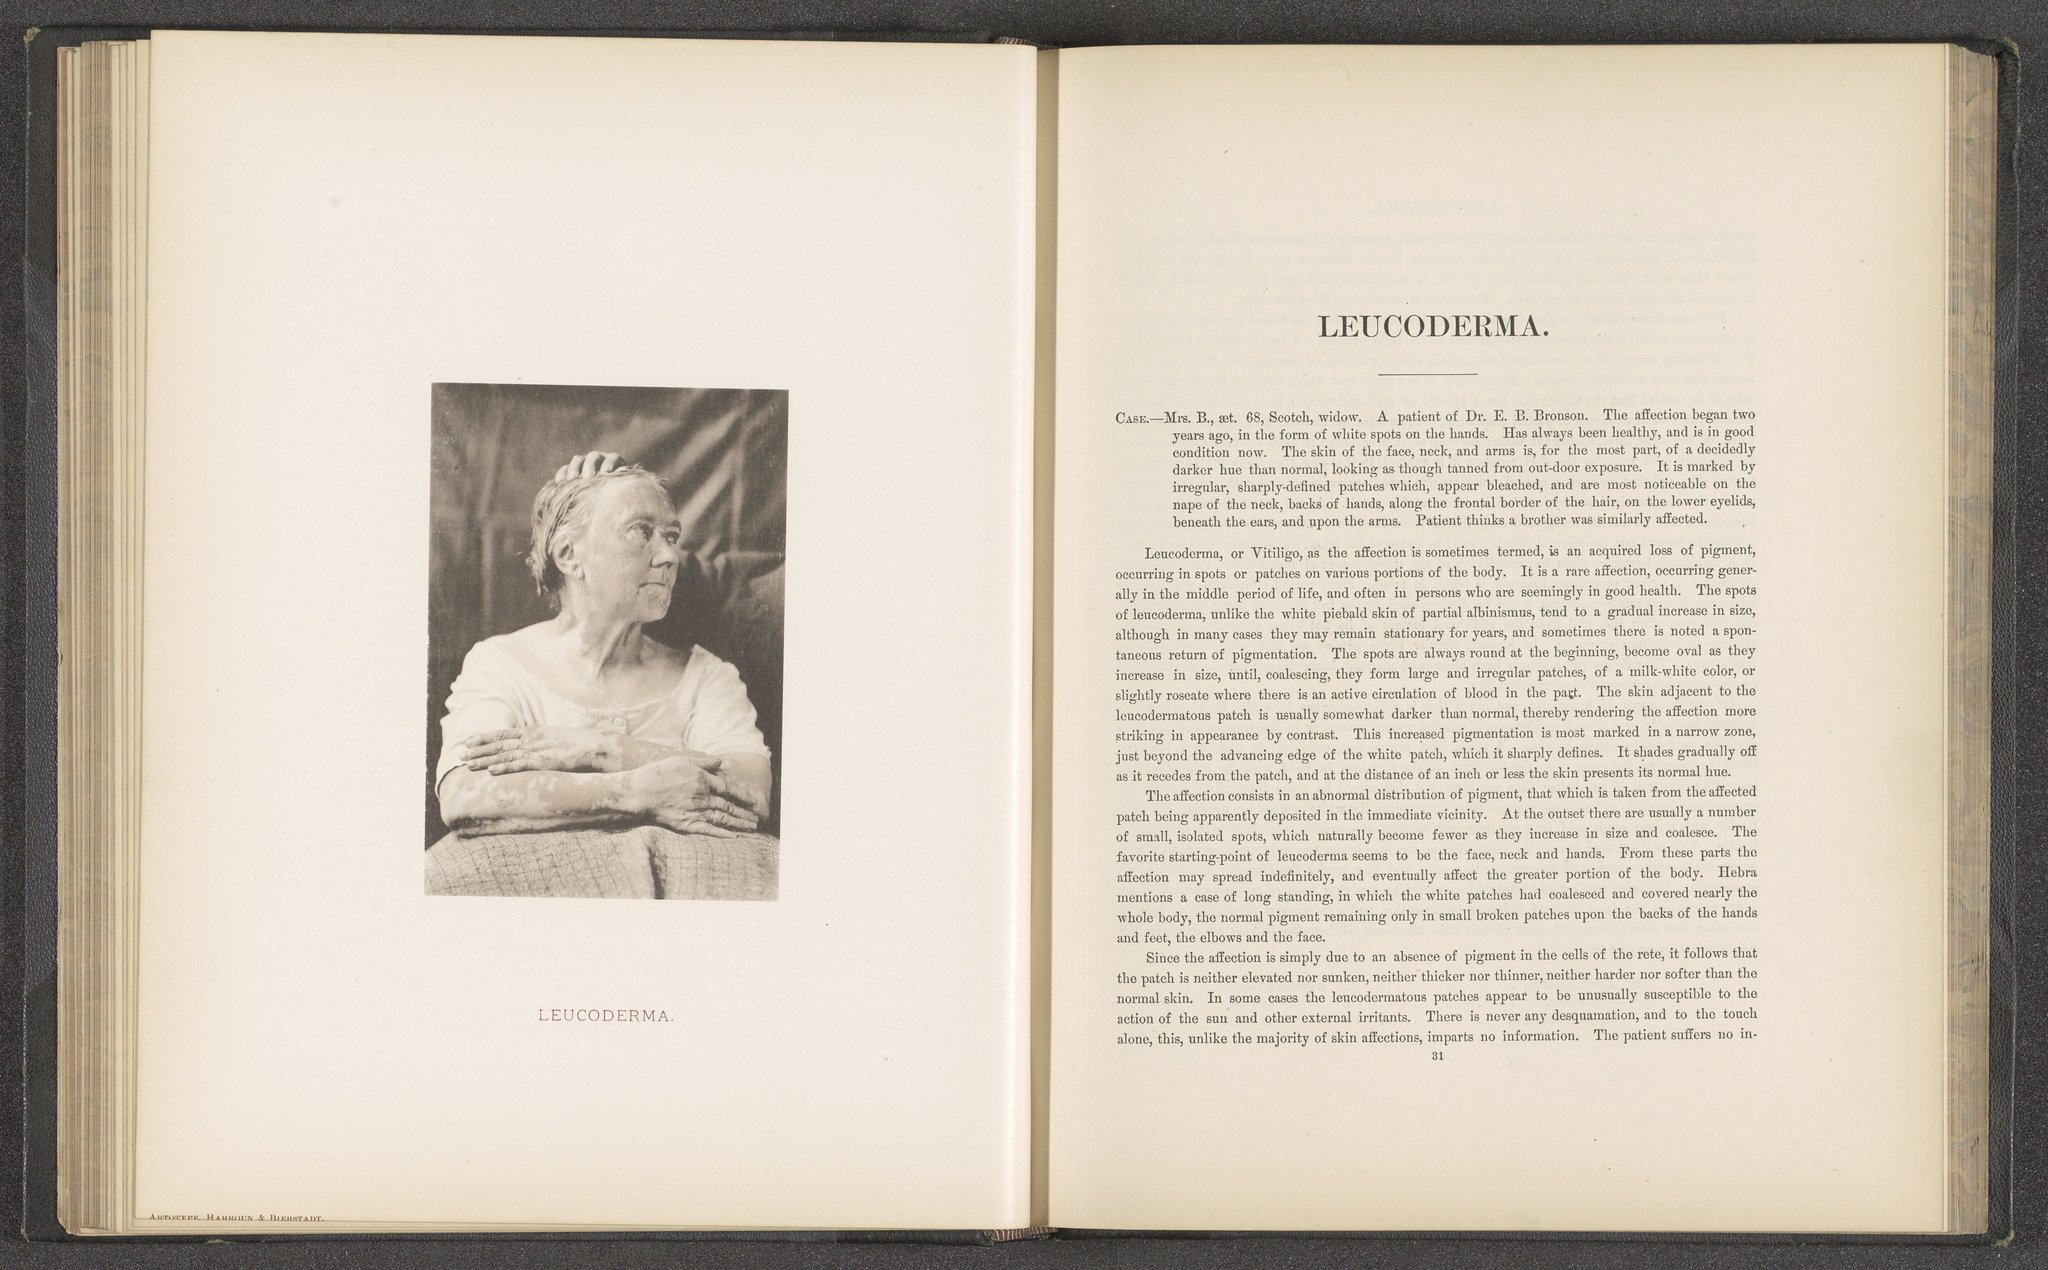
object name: page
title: Leucoderma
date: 1870-1881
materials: paper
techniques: photograph, hand coloring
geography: new york city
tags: adult woman, skin and venereal diseases